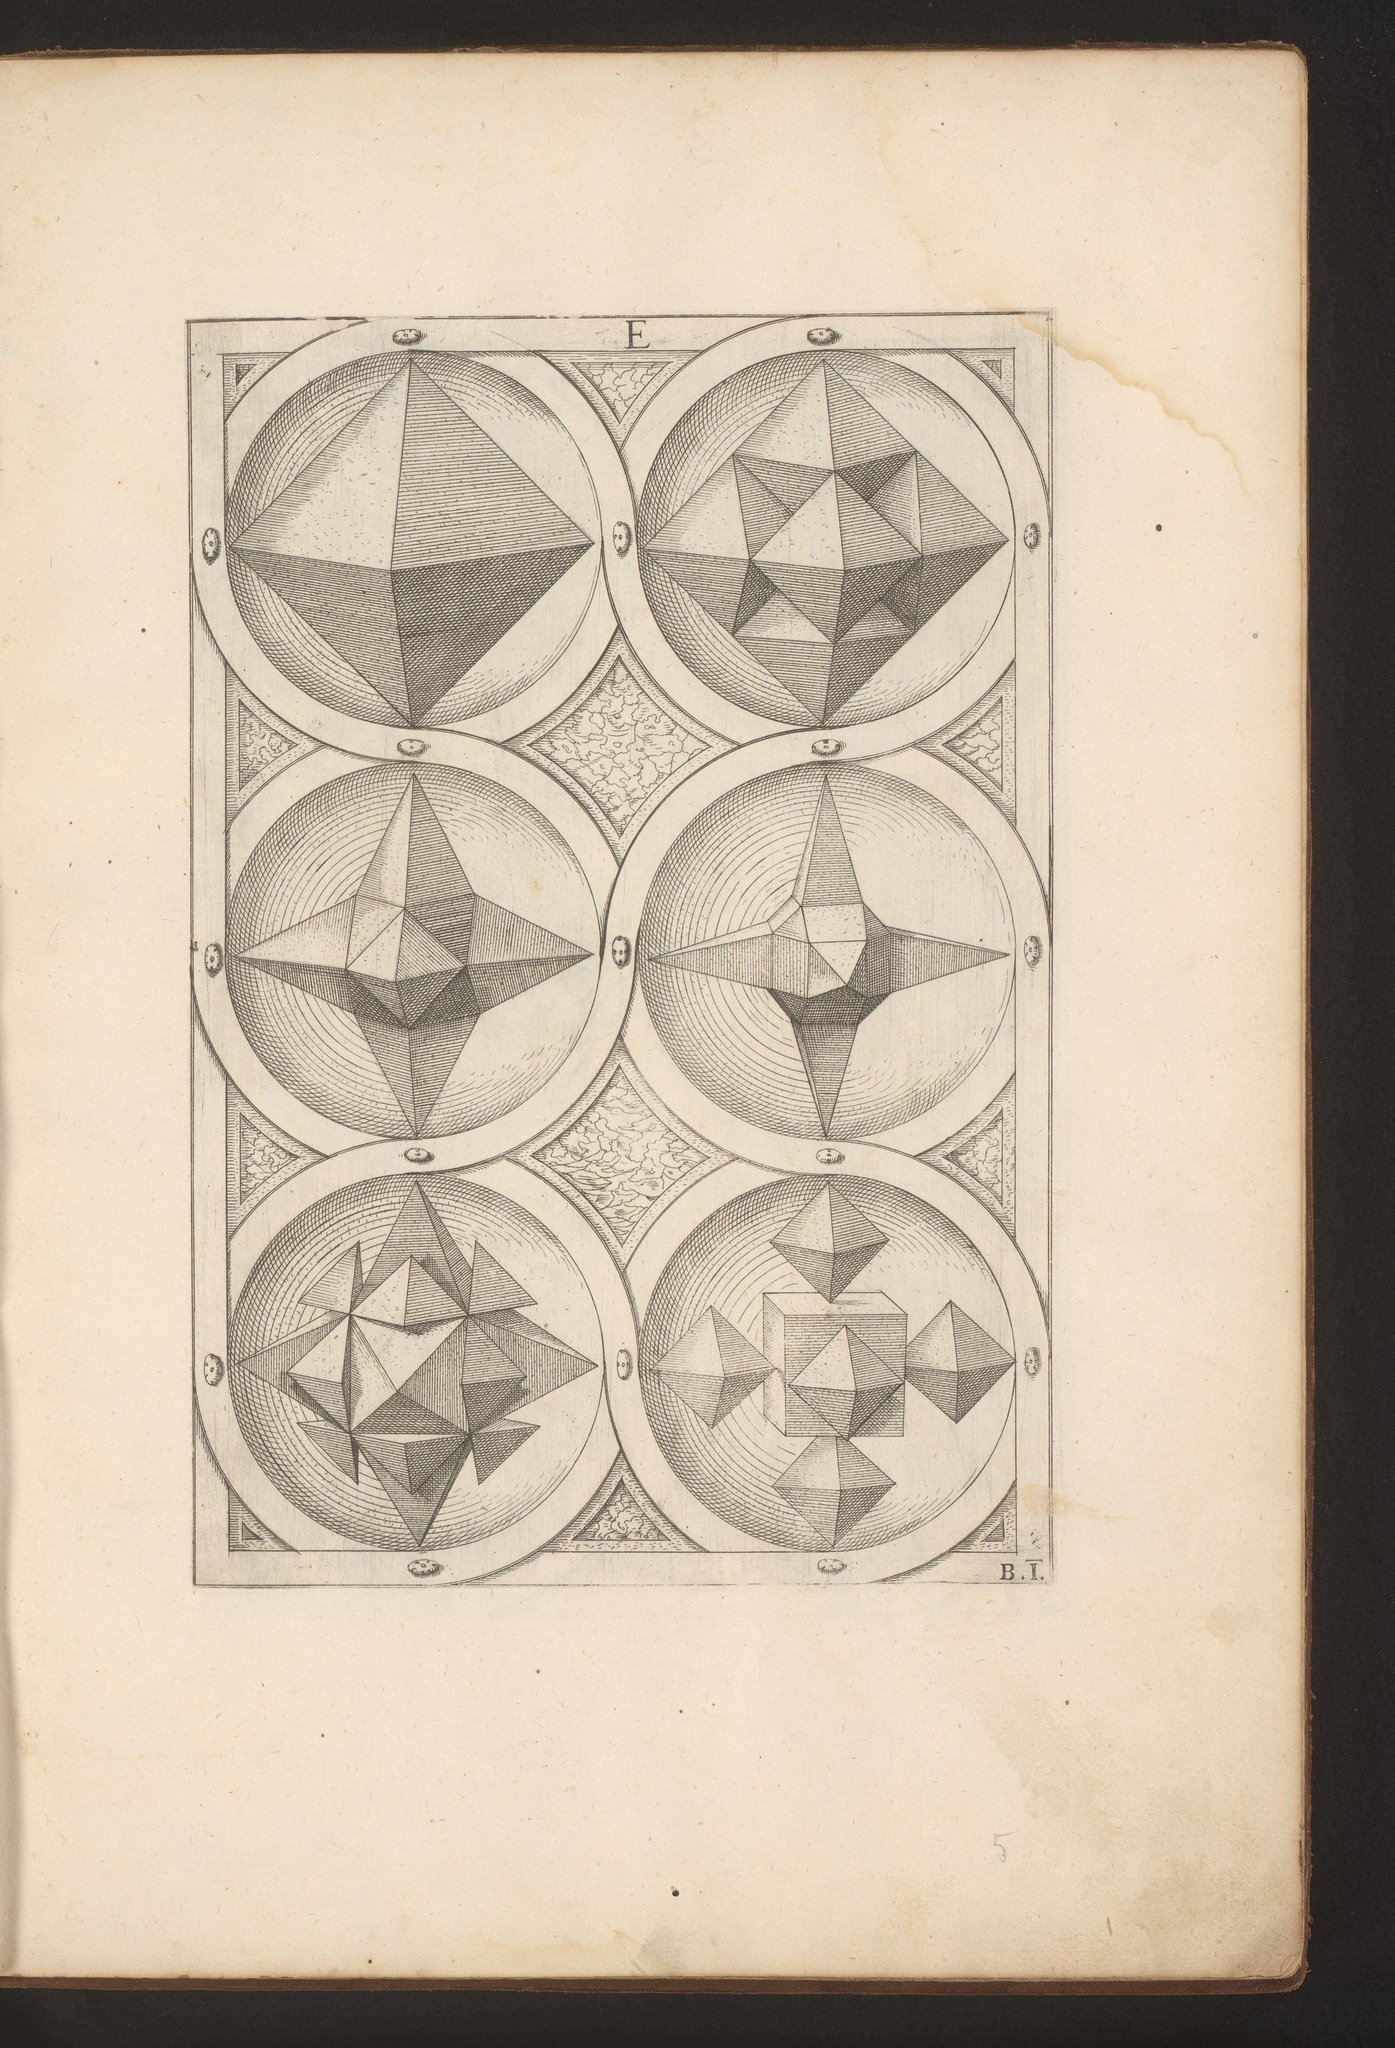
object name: print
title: Zes veelvlakken met een octaëder als uitgangspunt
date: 1568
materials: paper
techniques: etching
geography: nuremberg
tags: other polyhedrons, octahedron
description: De geometrische figuren (polyhedra) worden van boven naar beneden complexer. Rechtsonder genummerd: B.I. Deze prent maakt deel uit van een boek.